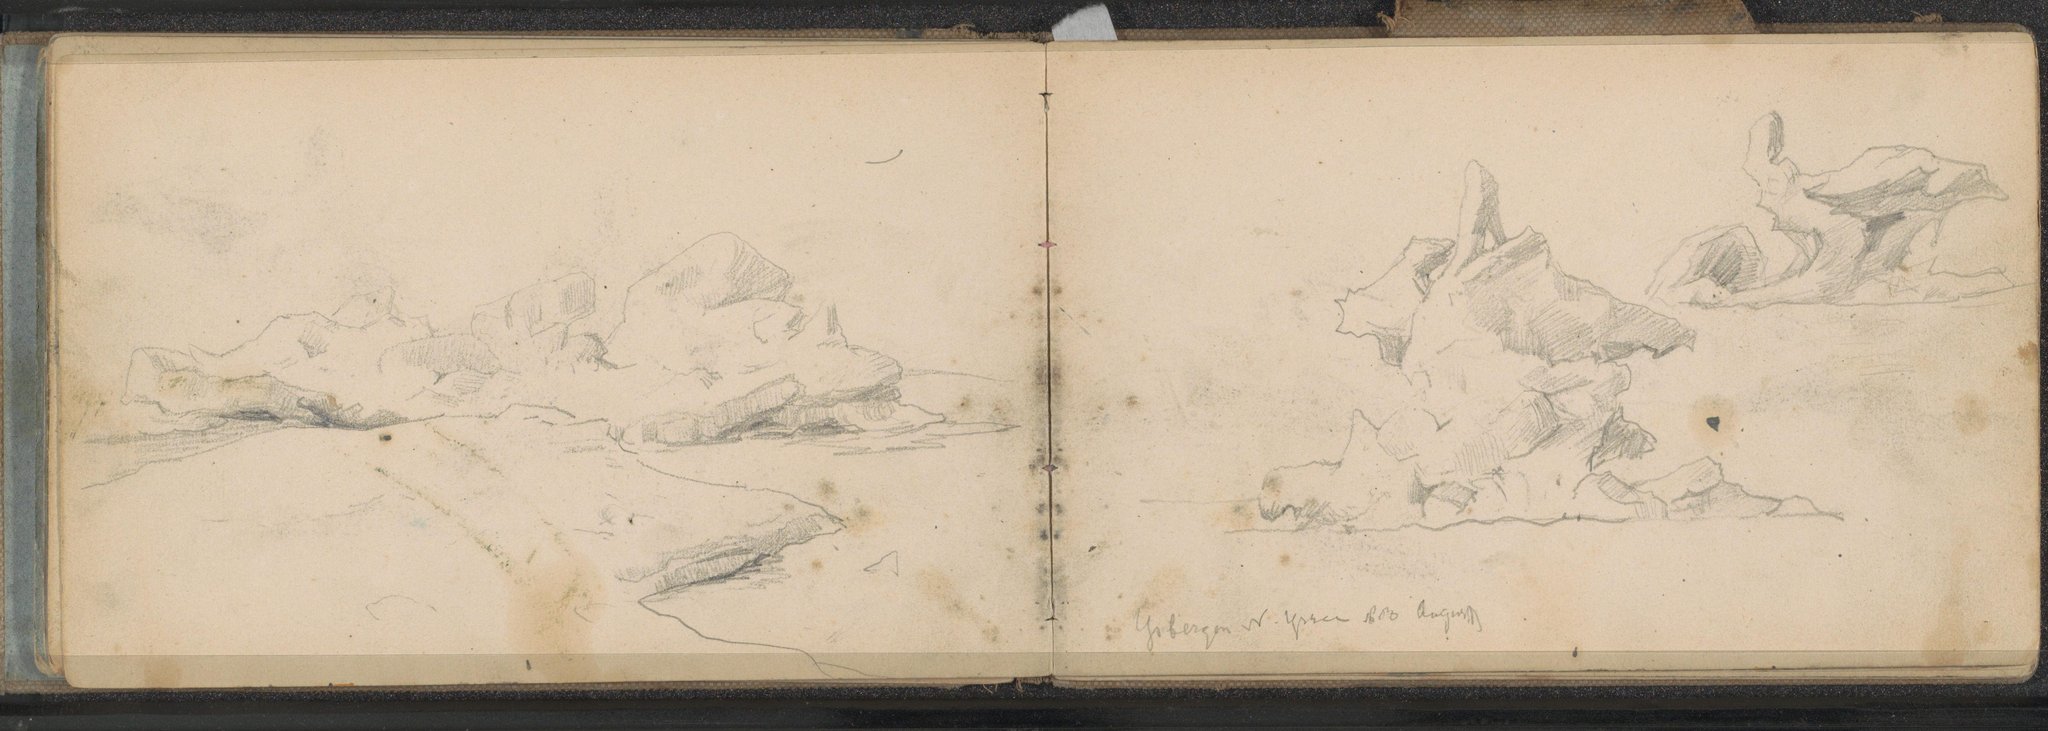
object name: sketchbook leaf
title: Kustgezicht met ijsbergen te Nova Zembla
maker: louis apol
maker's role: draughtsman, painter, print maker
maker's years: 1850-1936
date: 1880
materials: paper, pencil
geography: novaya zemlya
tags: iceberg, coast (in polar regions)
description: Blad 22 verso uit een schetsboek met 35 bladen betekend tijdens de expeditie naar Nova Zembla in 1880.